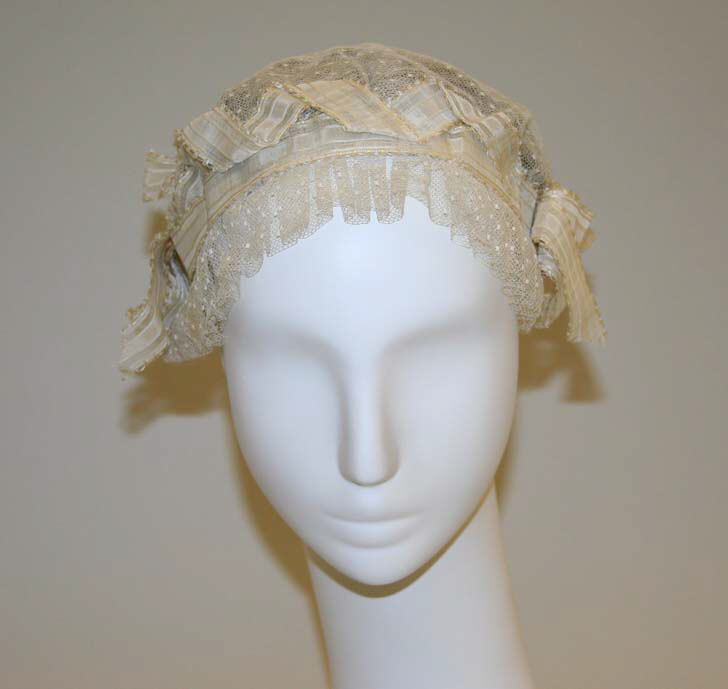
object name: cap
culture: american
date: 1801-1900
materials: cotton, metal, silk